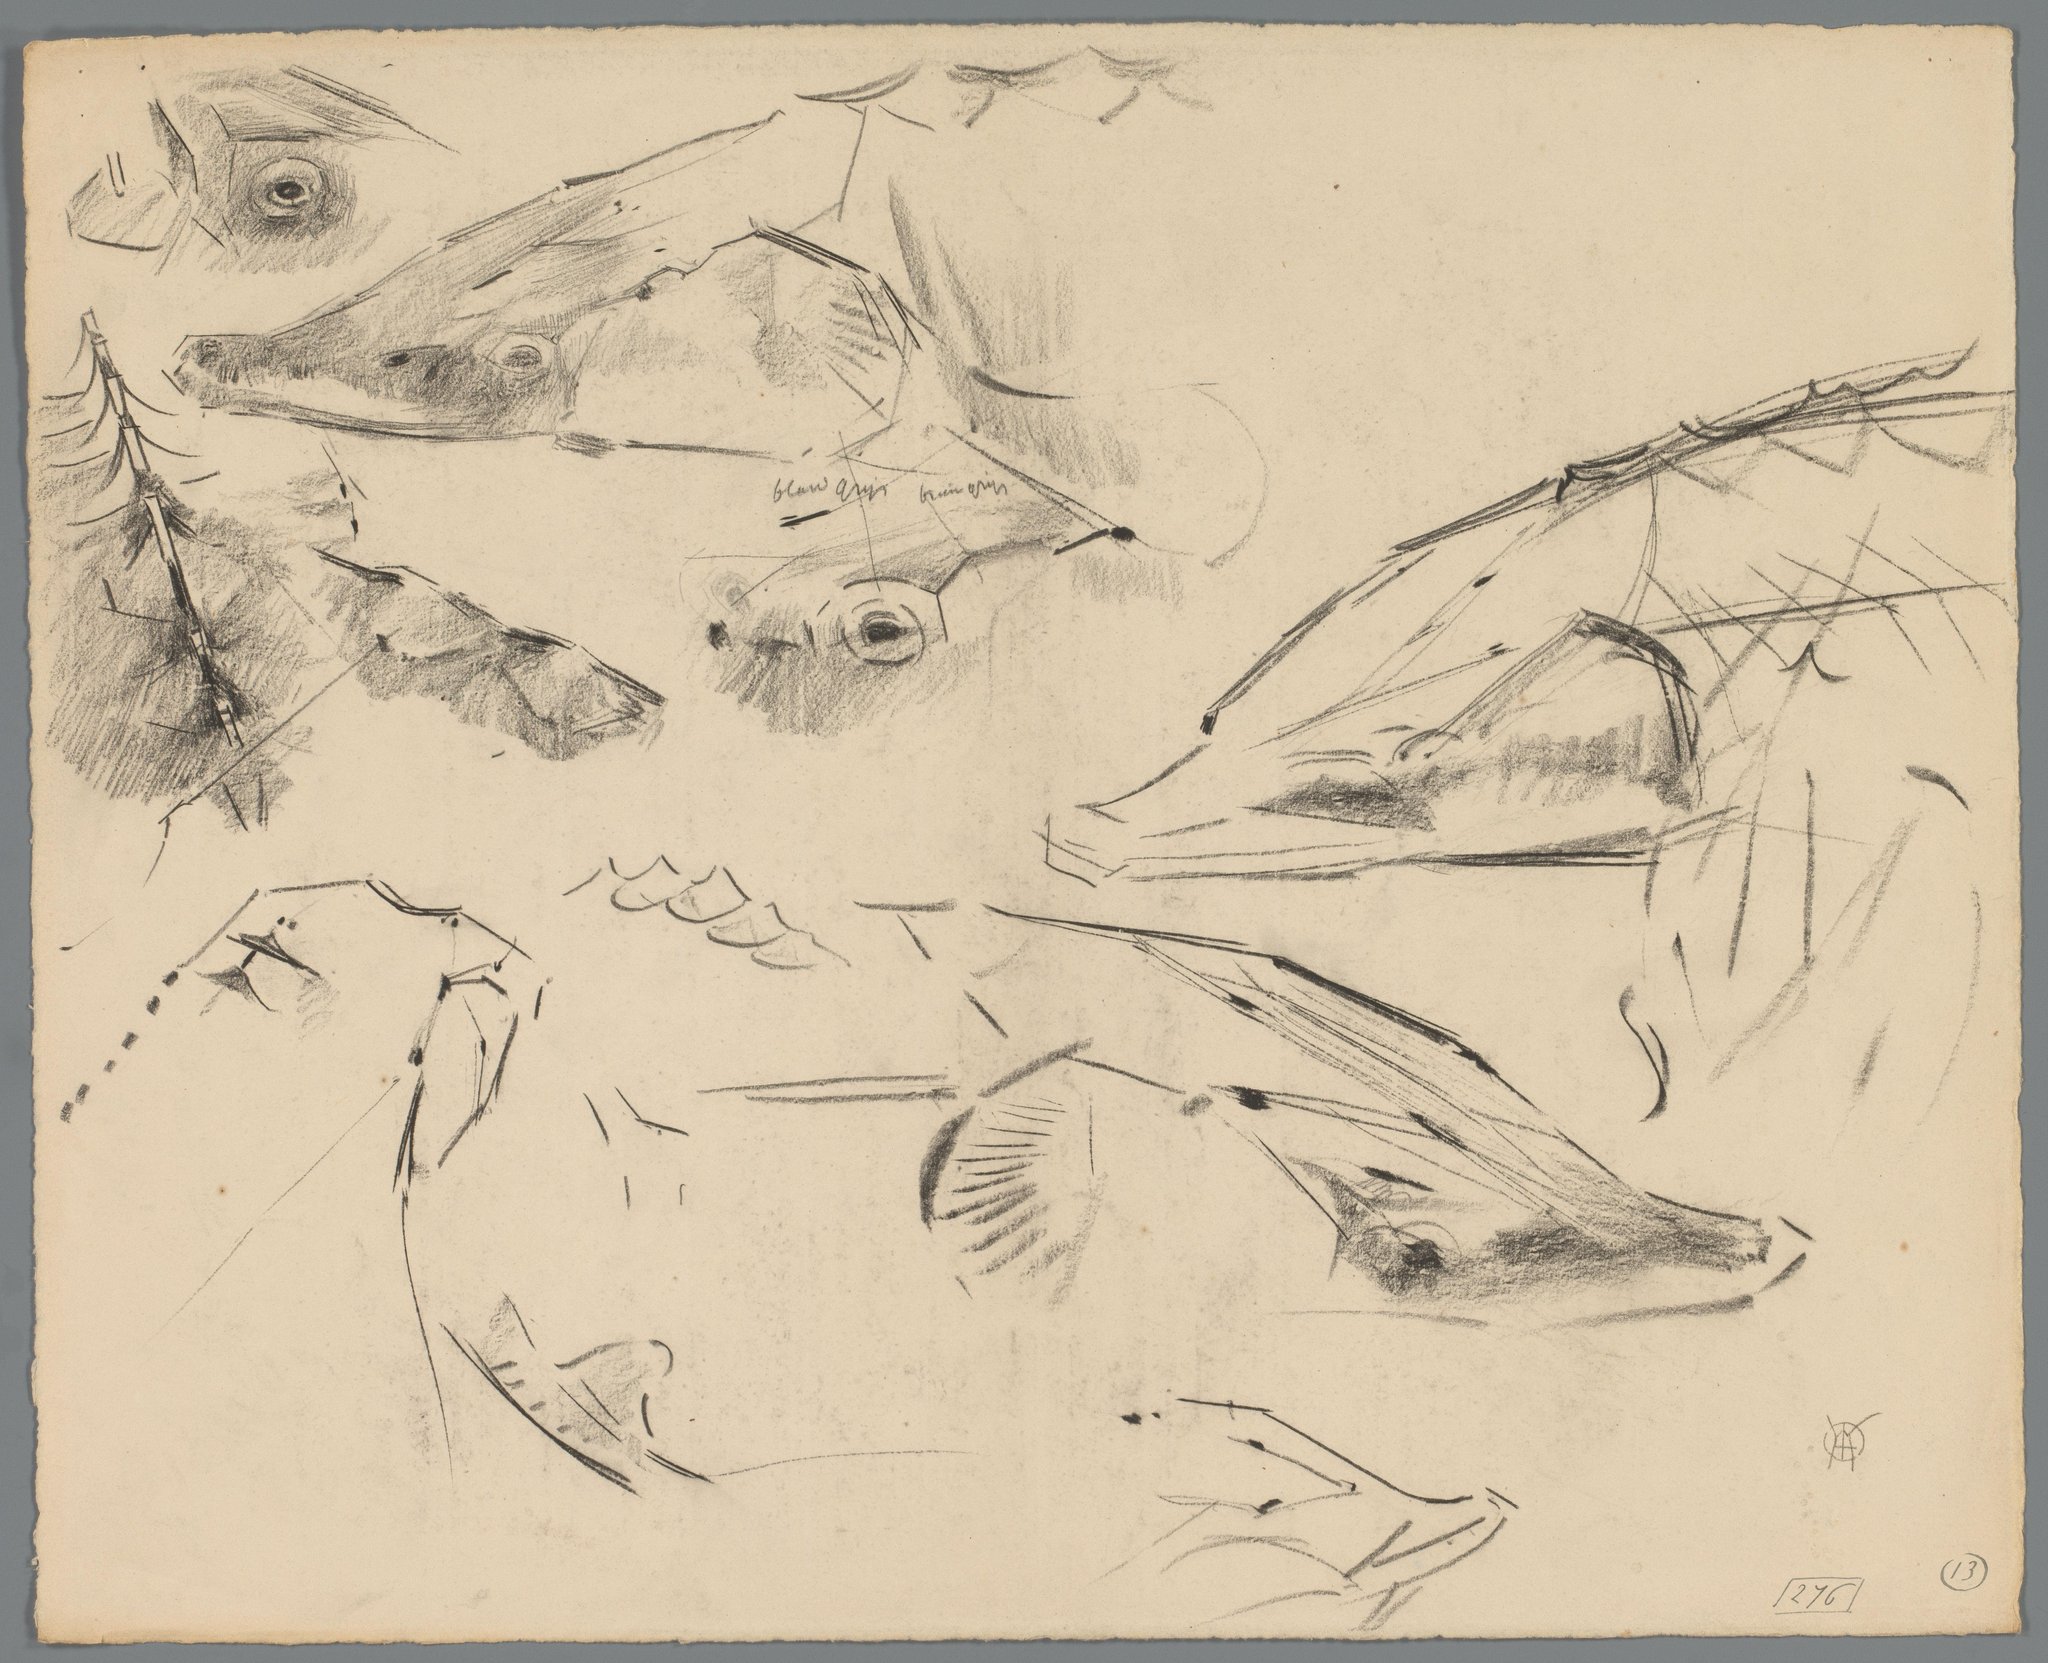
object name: drawing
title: Studies van een steur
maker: gerrit willem dijsselhof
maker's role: designer, draughtsman, print maker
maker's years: 1866-1924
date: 1876-1924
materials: chalk, paper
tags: bony fishes: sturgeon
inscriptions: number: ‘276’, number: ‘13’